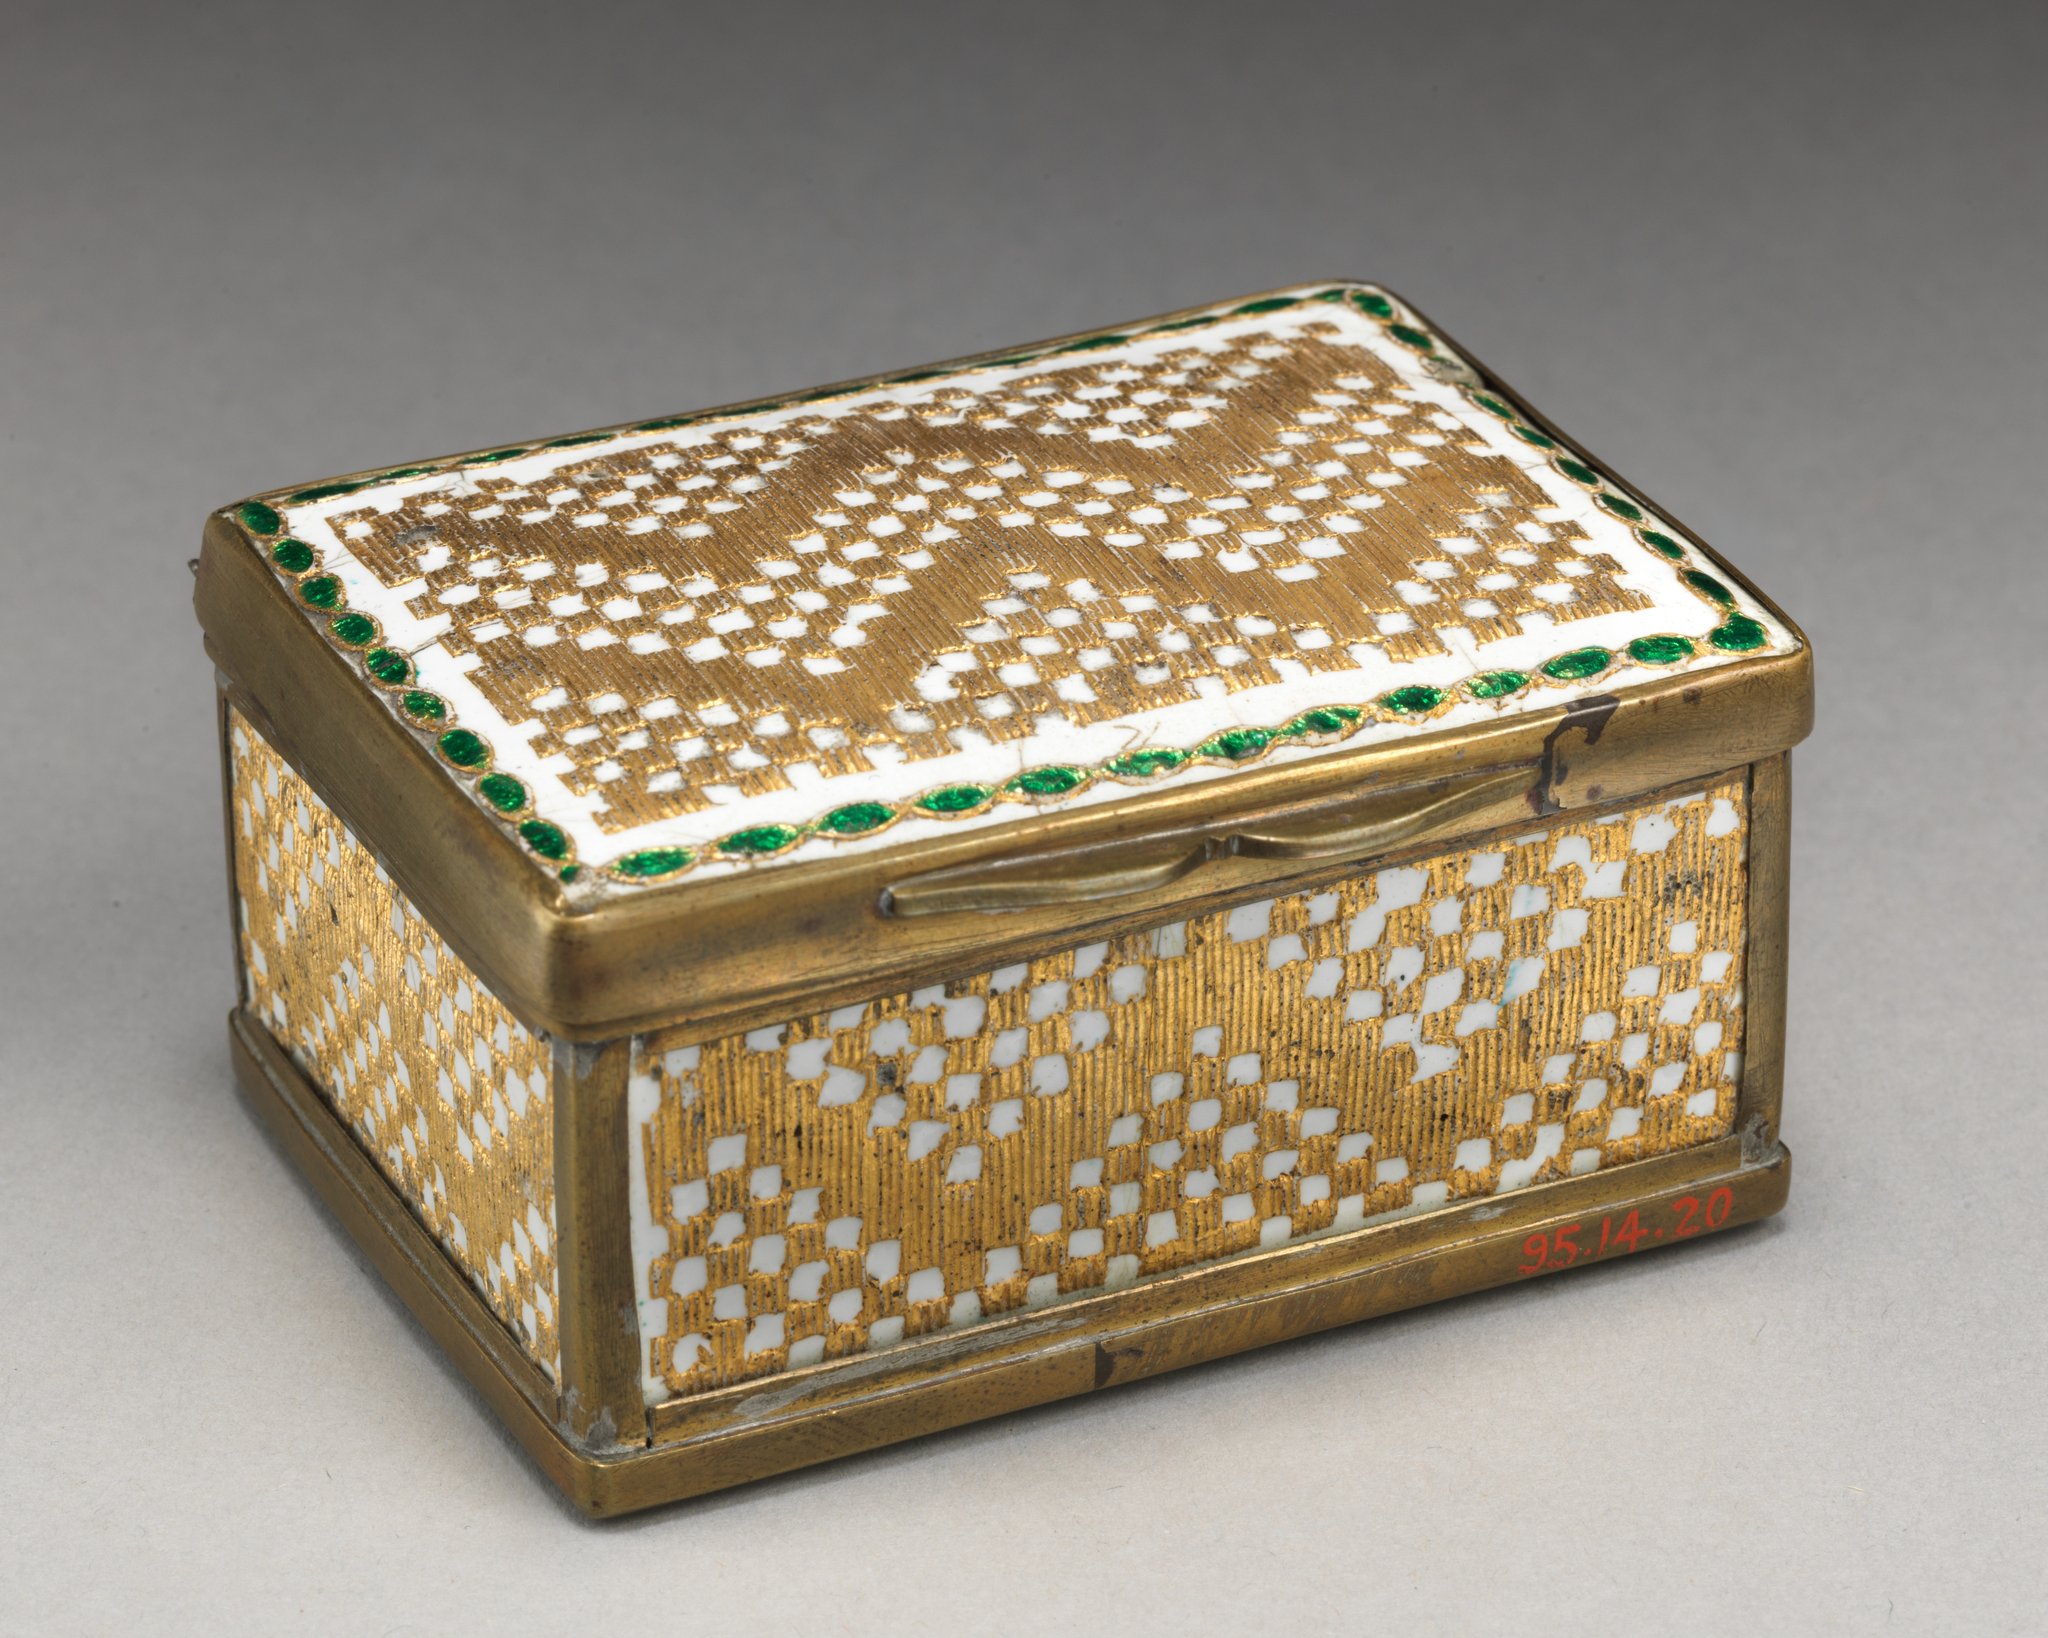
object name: snuffbox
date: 1701-1800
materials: copper, enamel, gold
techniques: inlay